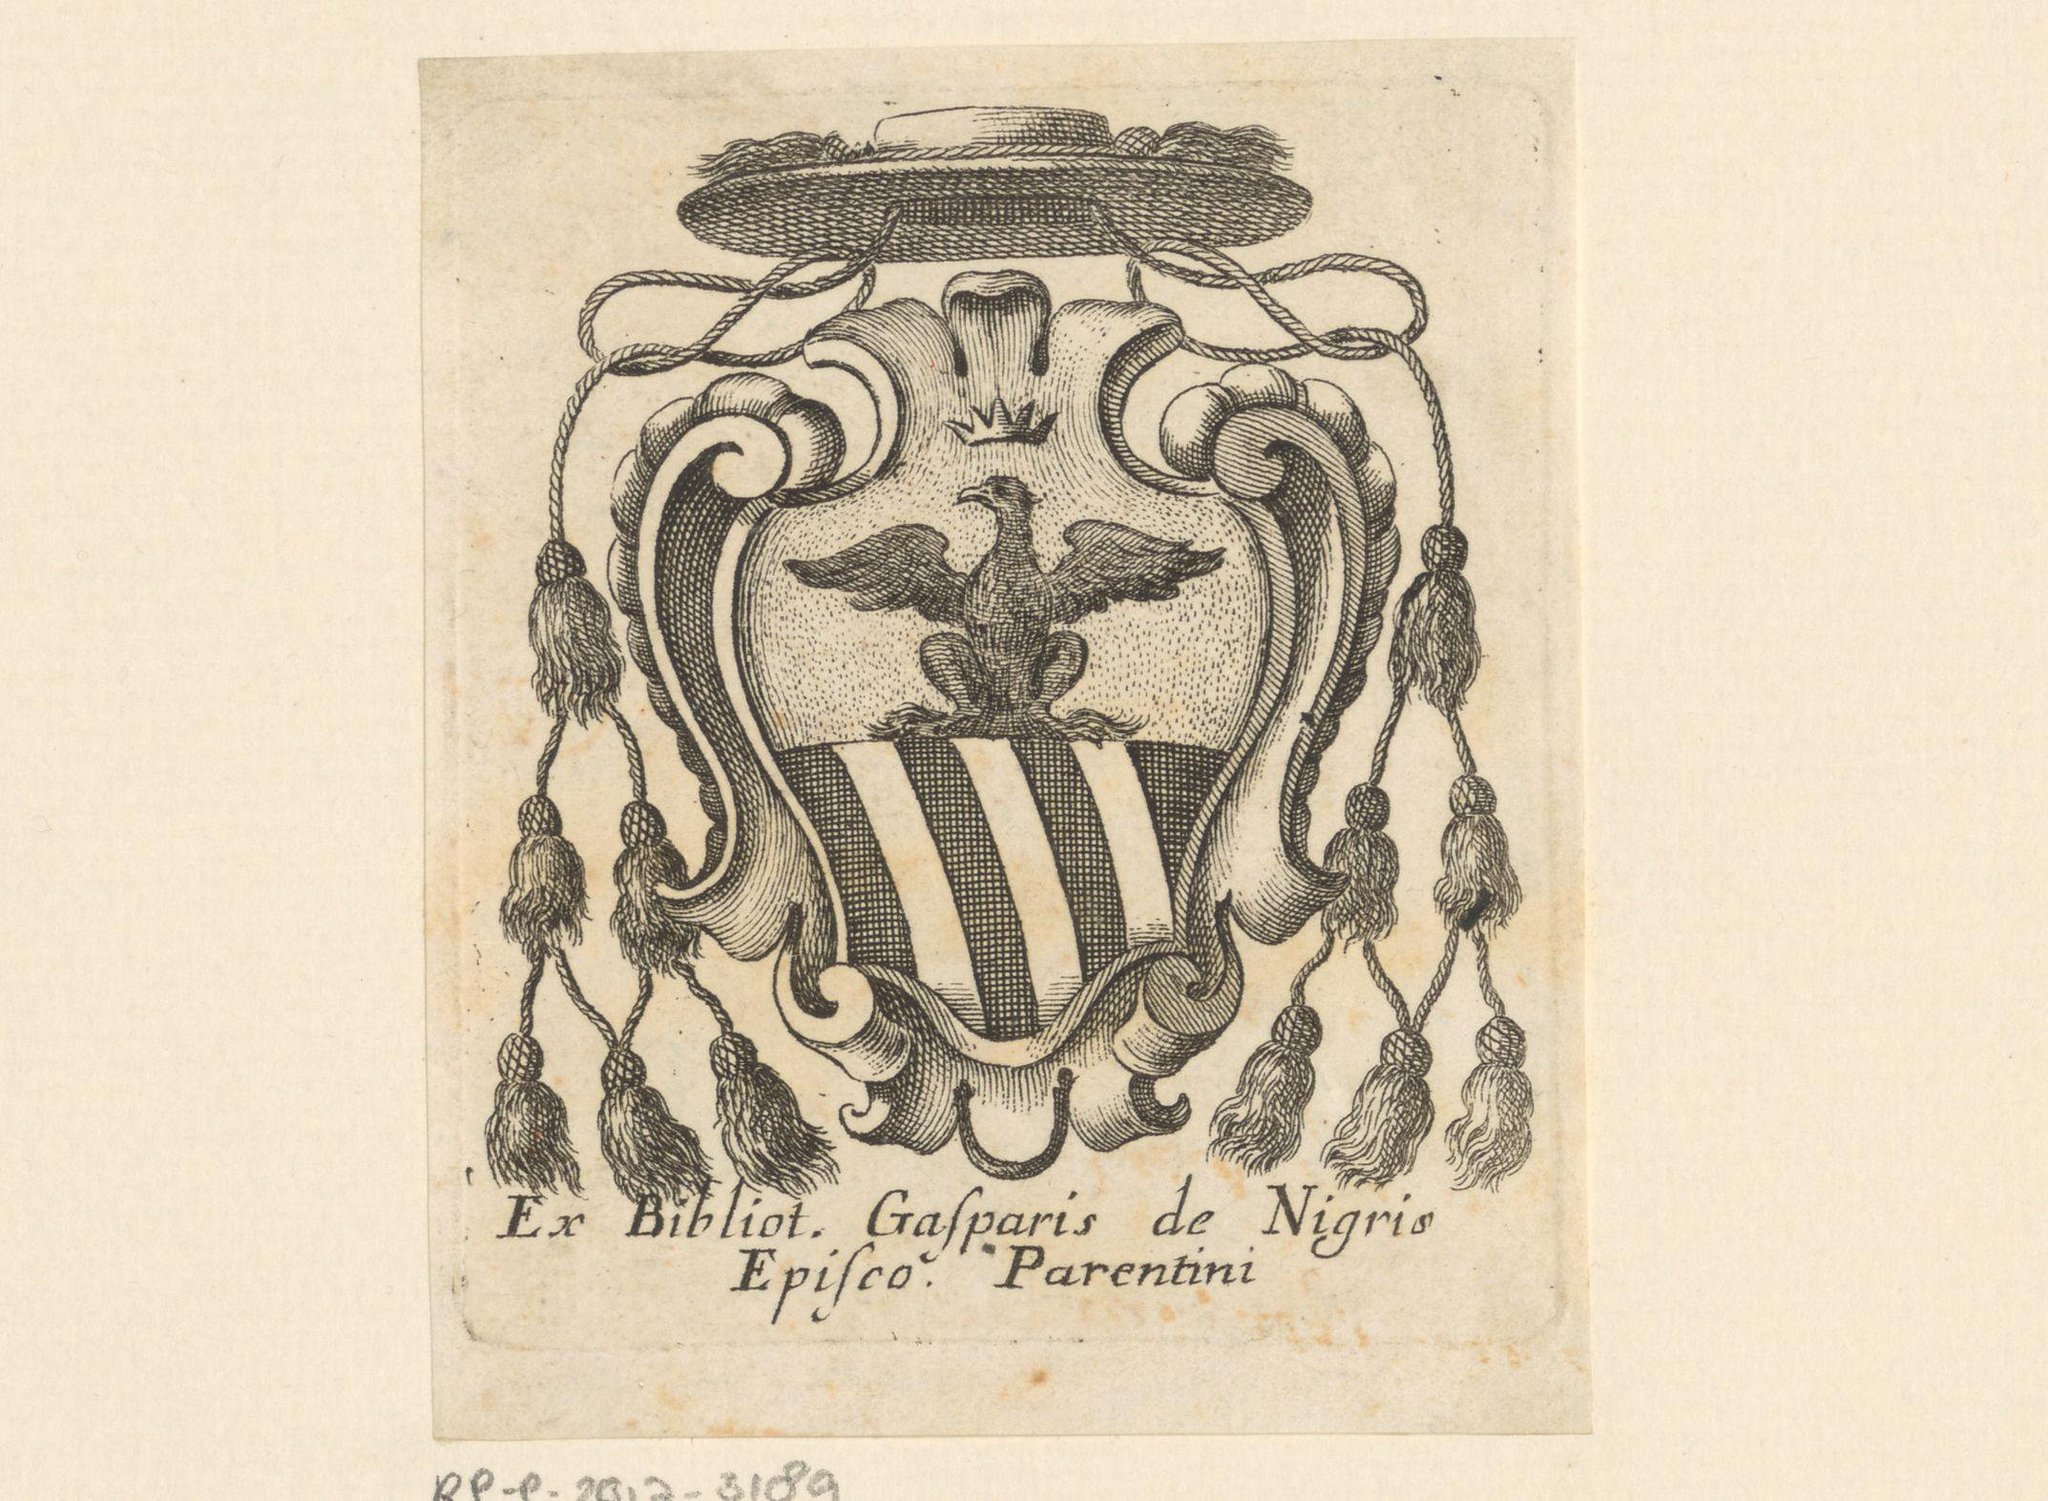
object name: bookplate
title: Ex biblioteca Gasparis de Nigris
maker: Anonymous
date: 1700-1800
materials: paper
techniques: etching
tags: predatory birds: eagle, insignia of cardinal, e.g. hat, mantle, armorial bearing, heraldry